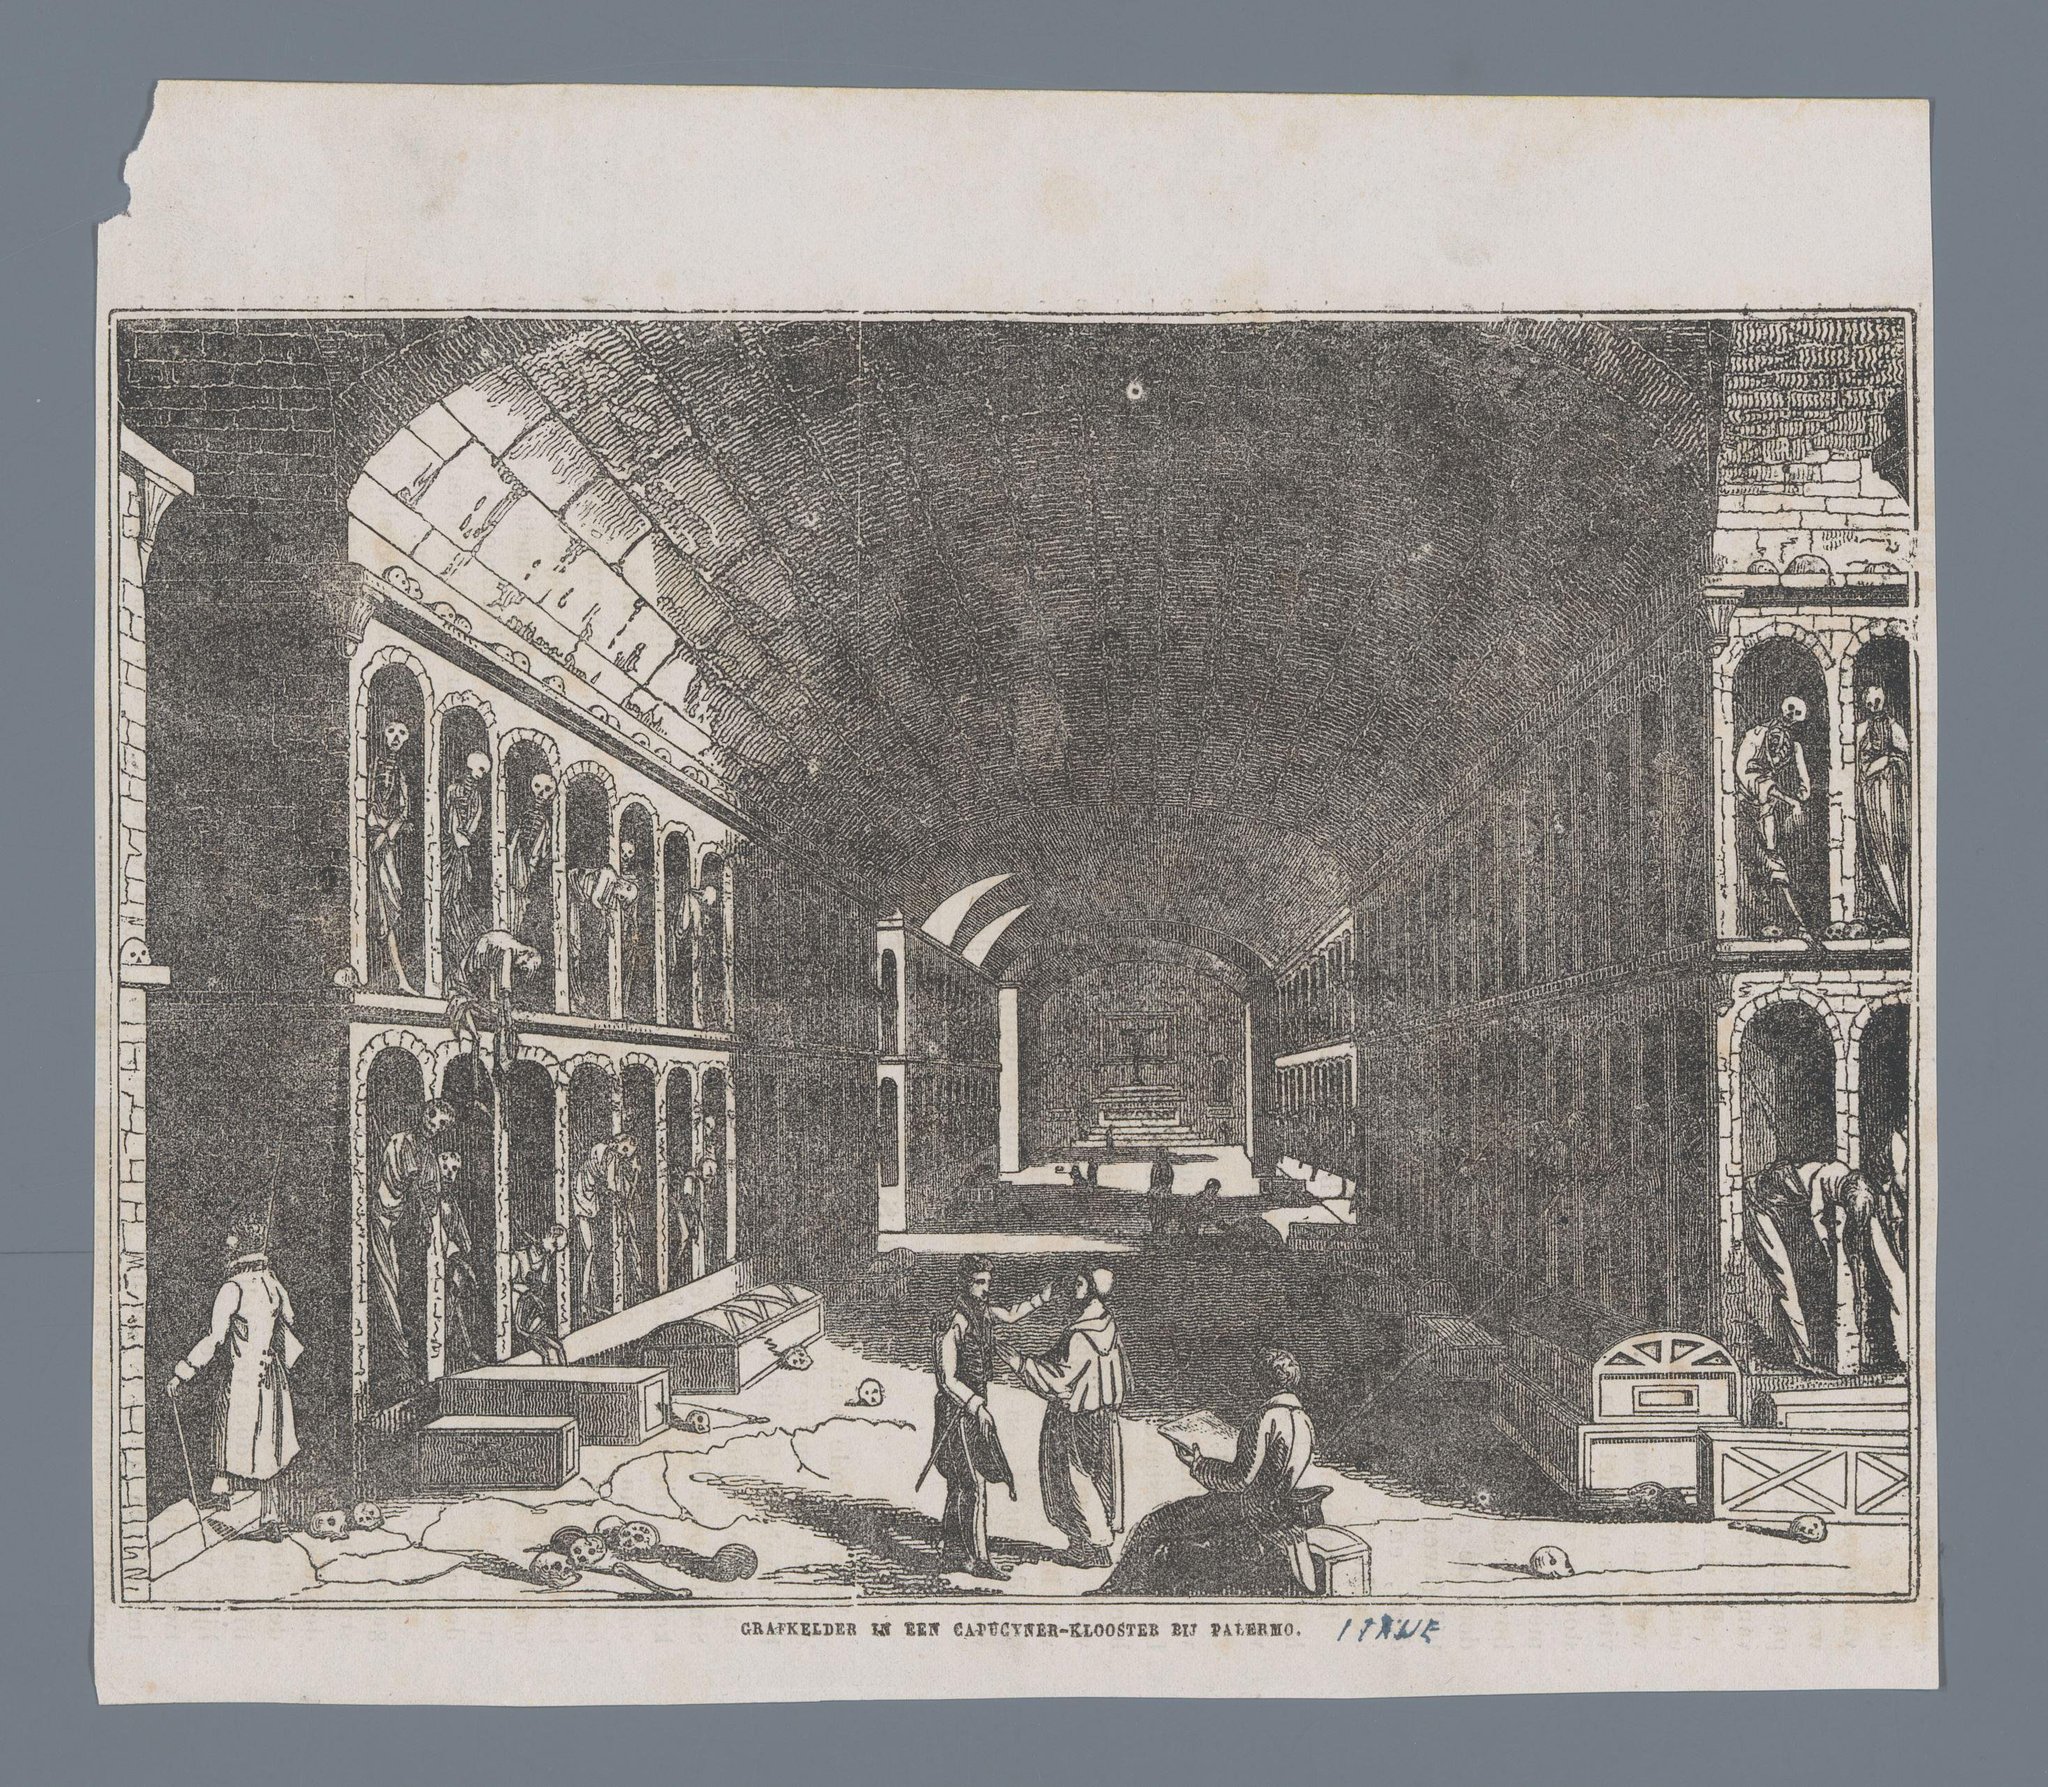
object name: print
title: Grafkelder in een Capucyner-klooster bij Palermo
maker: Anonymous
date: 1837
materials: paper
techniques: letterpress printing, engraving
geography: amsterdam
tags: abbey, monastery, convent ~ roman catholic church, catacombs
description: Prent uit: Nederlandsch Magazijn ter verspreiding van algemeene en nuttige kundigheden. Amsterdam: Gebroeders Diederichs, 1837, p. 116.